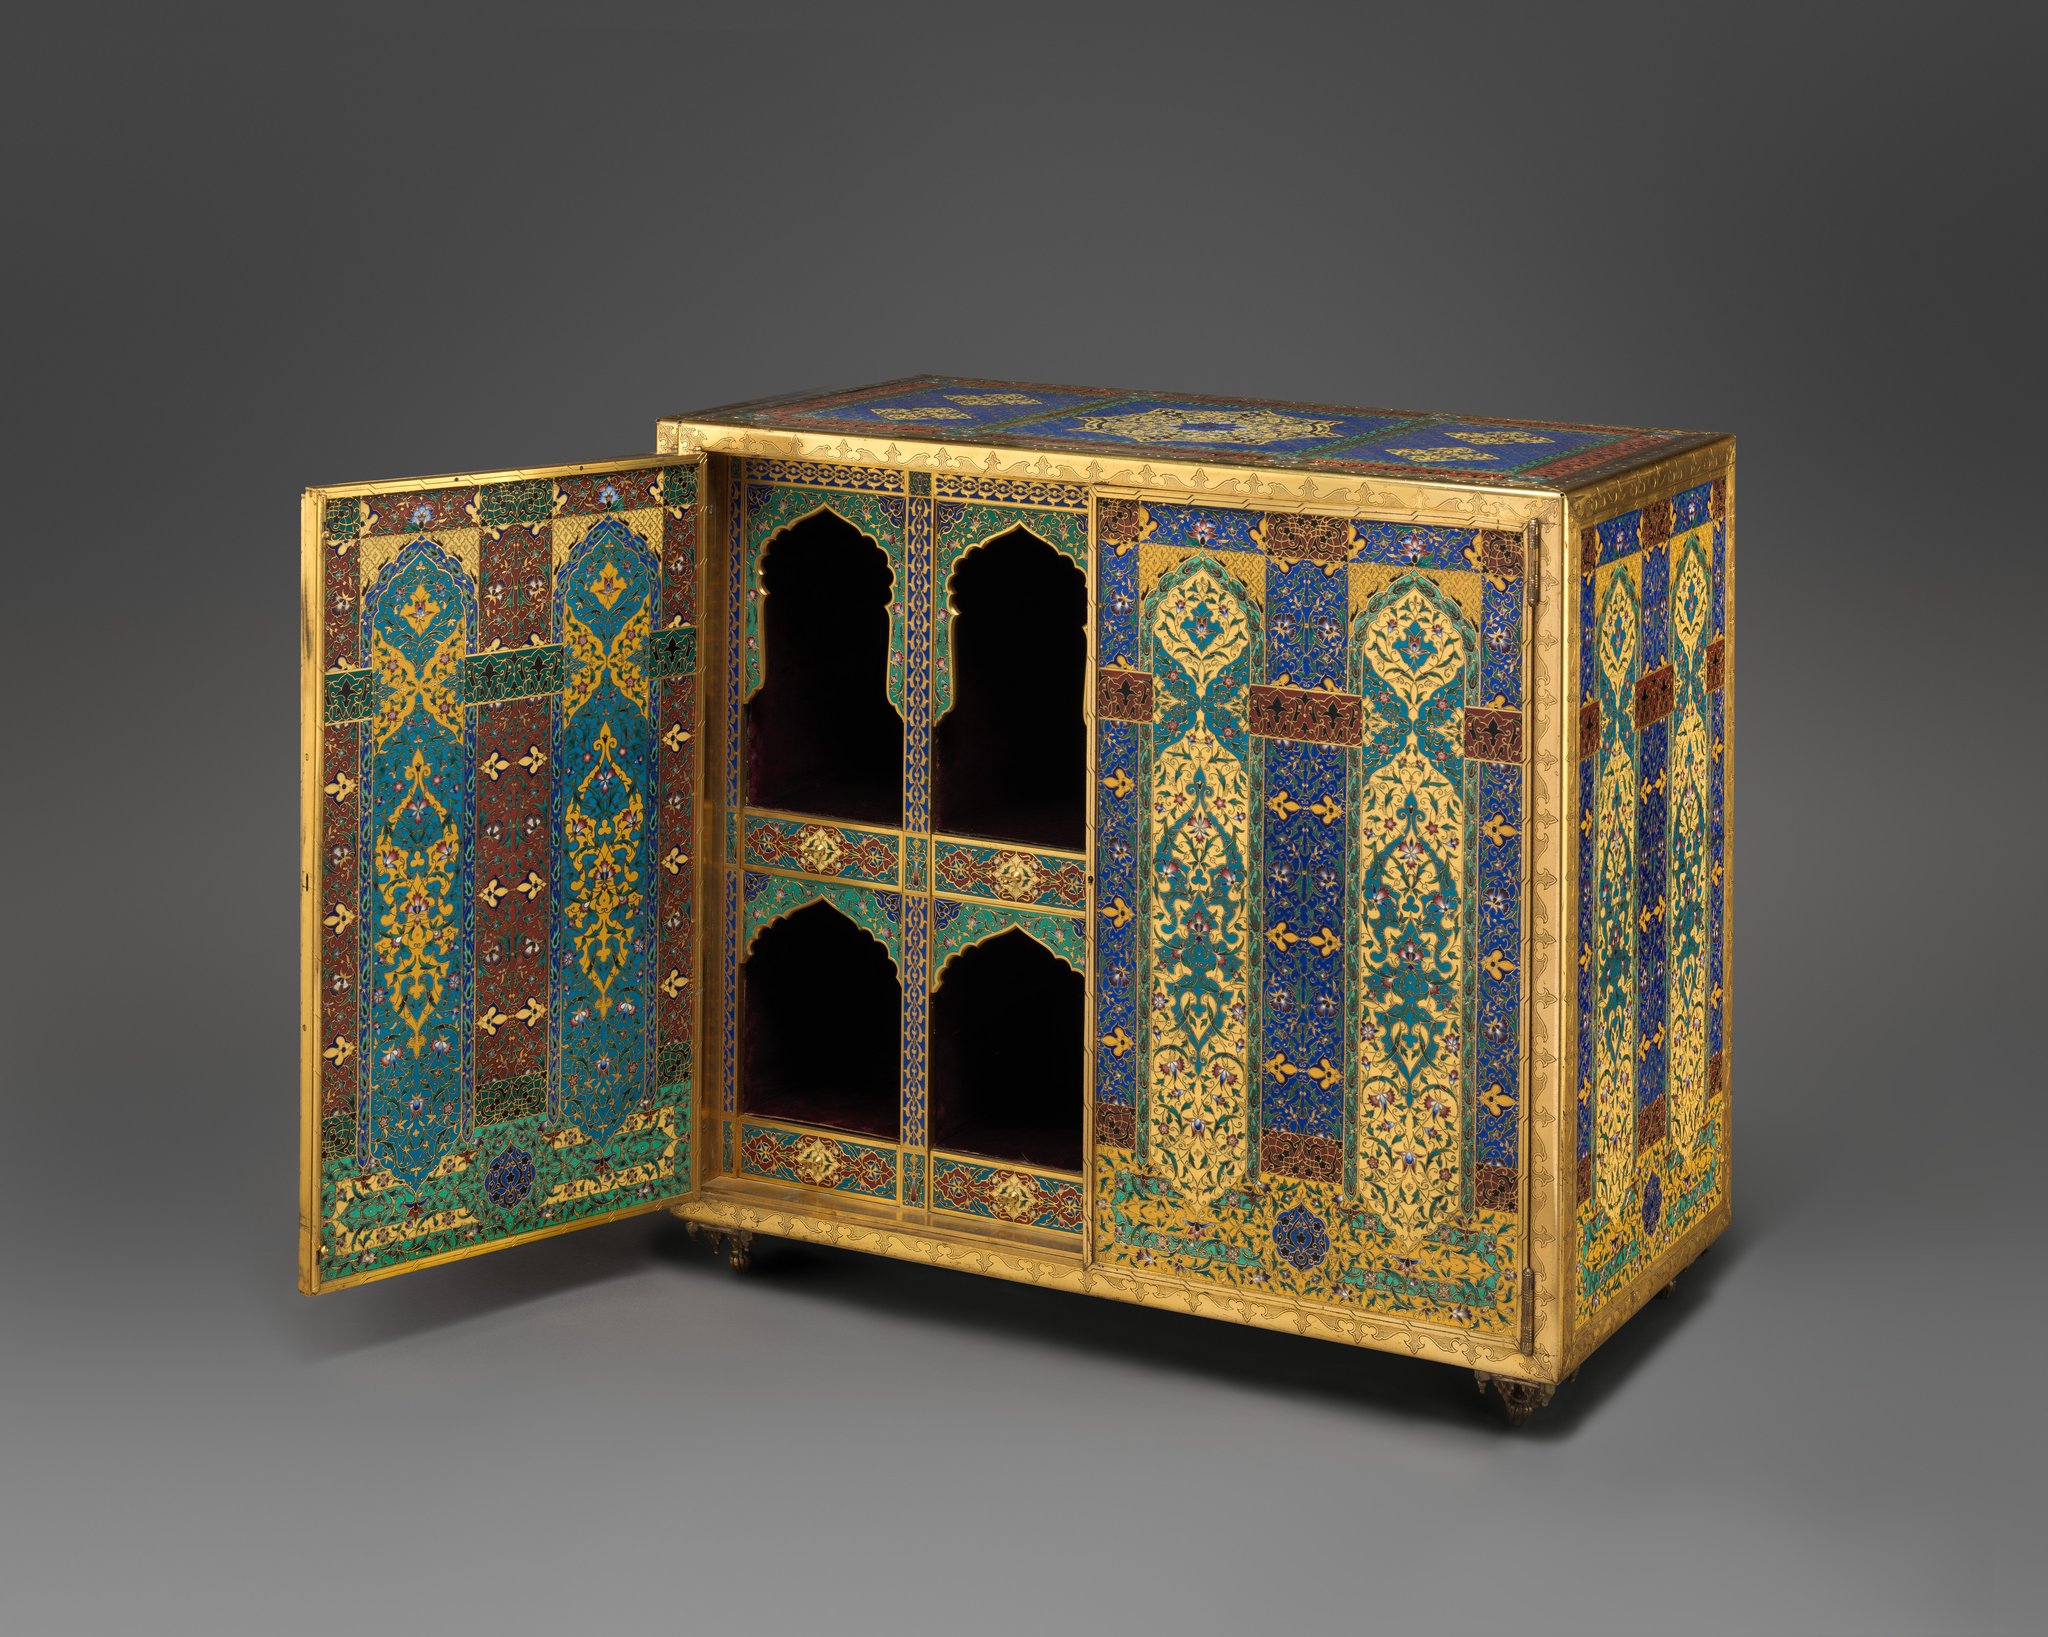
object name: cabinet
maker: maison barbedienne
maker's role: maker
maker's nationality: french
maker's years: 1834-1954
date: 1867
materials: brass, enamel, velvet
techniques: enamel, polychrome